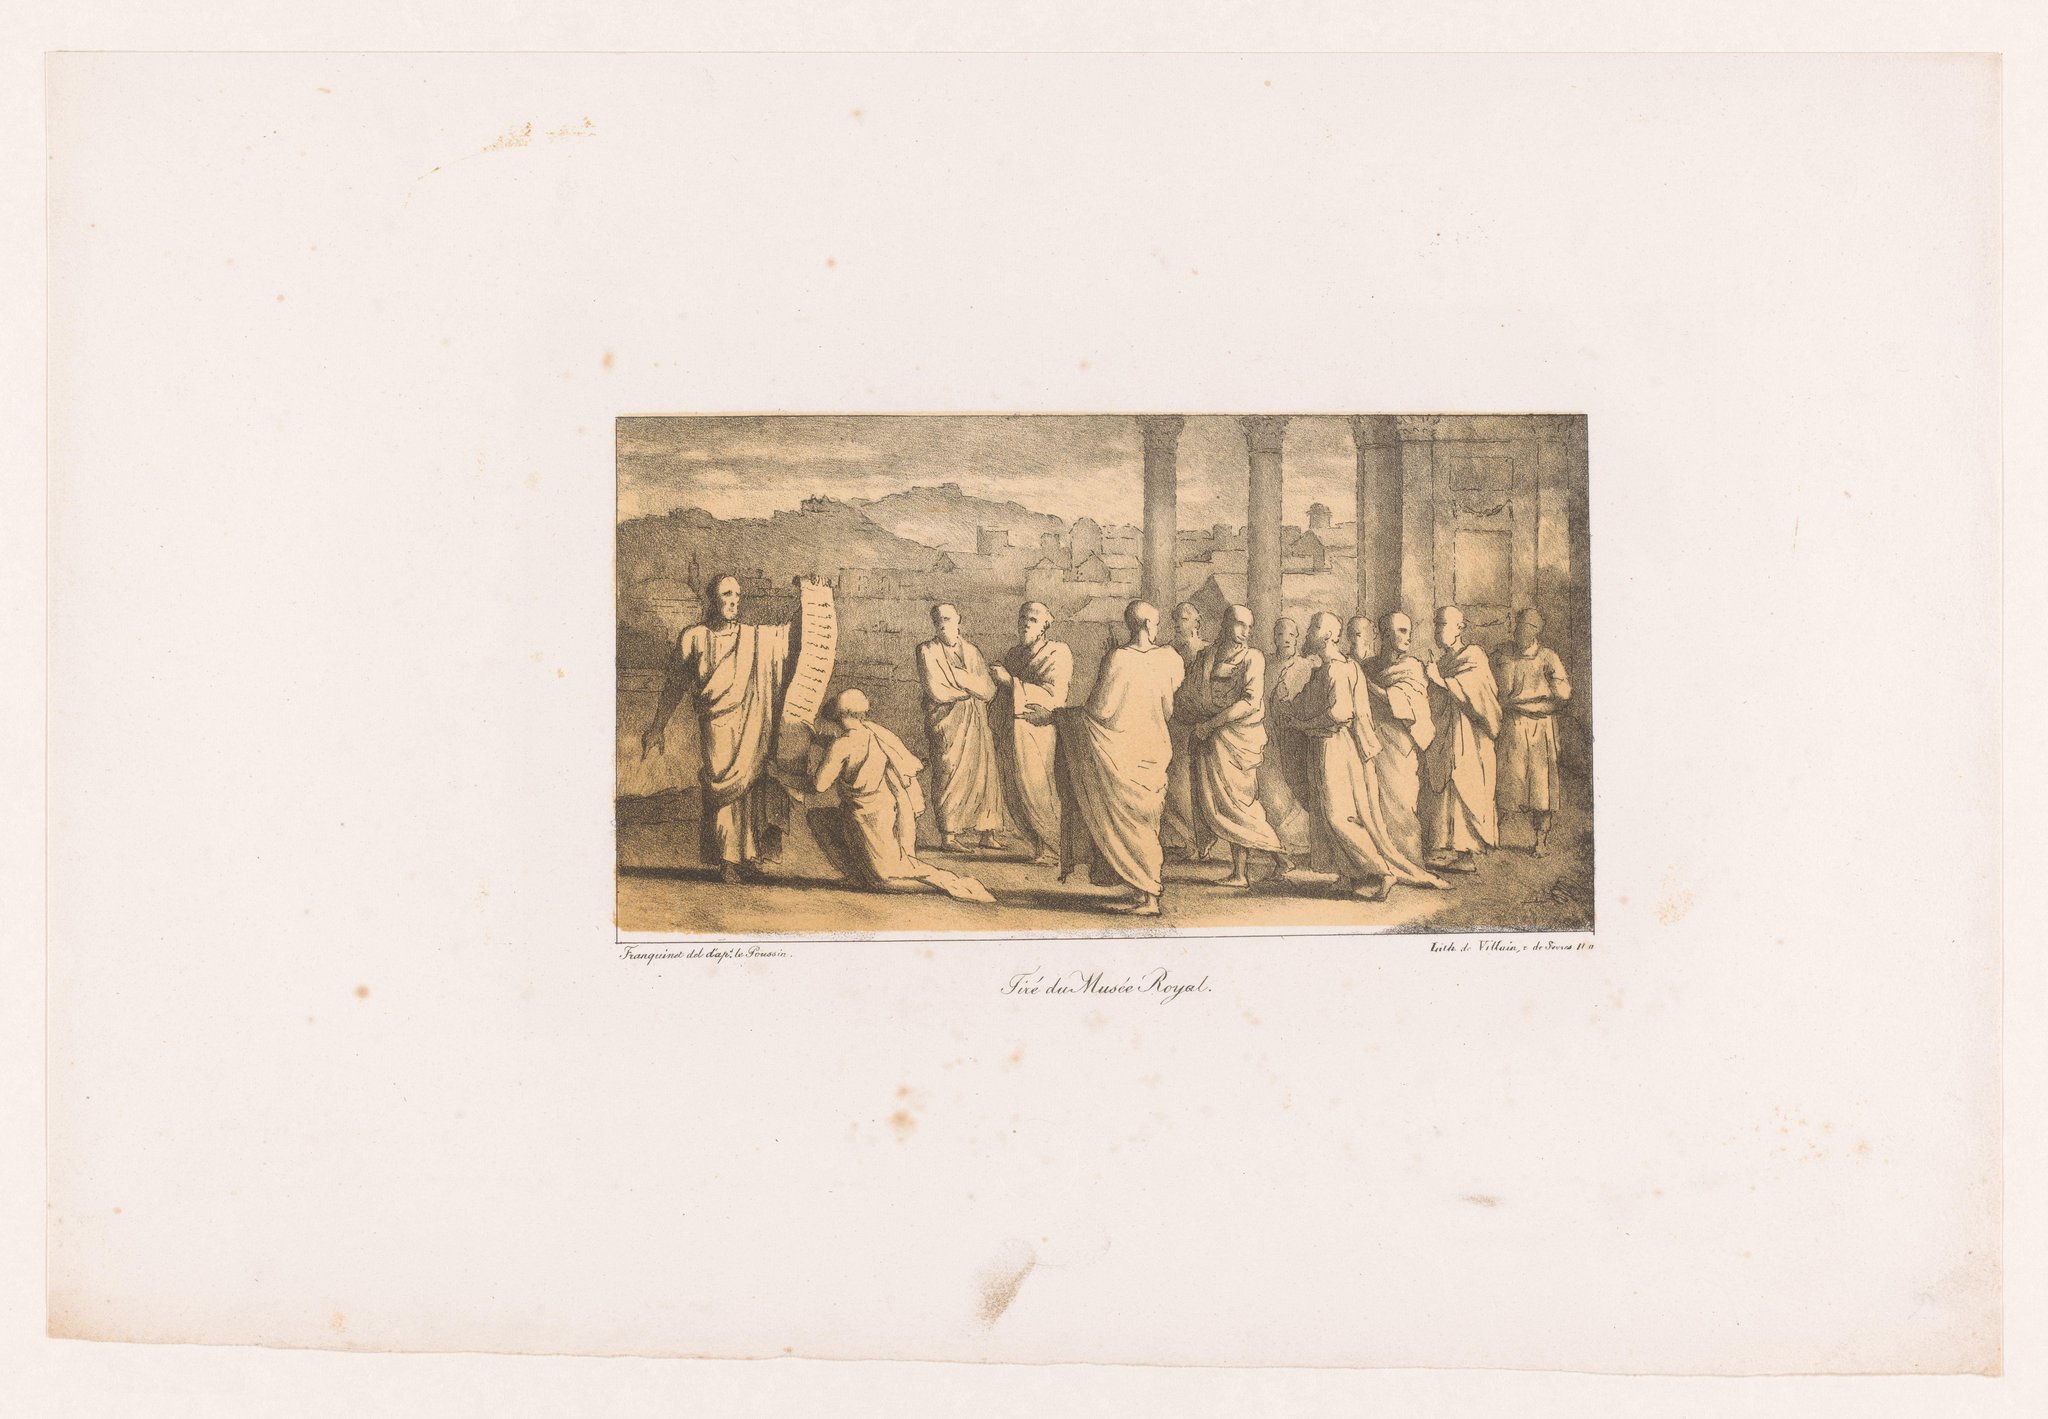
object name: print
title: Traditio Legis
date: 1809-1854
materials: paper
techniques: tone lithography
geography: paris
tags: christ giving a scroll (the law) to paul; apostle(s) present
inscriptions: collector's mark: Lugt 2233, collector's mark: Lugt 2228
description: Alle figuren dragen toga's. Christus, meest links, houdt een stuk papier omhoog. Zijn apostel Paulus zit voor hem geknield en leest wat op het papier staat. Daarachter staan de andere apostelen. De groep staat in een colonnade.